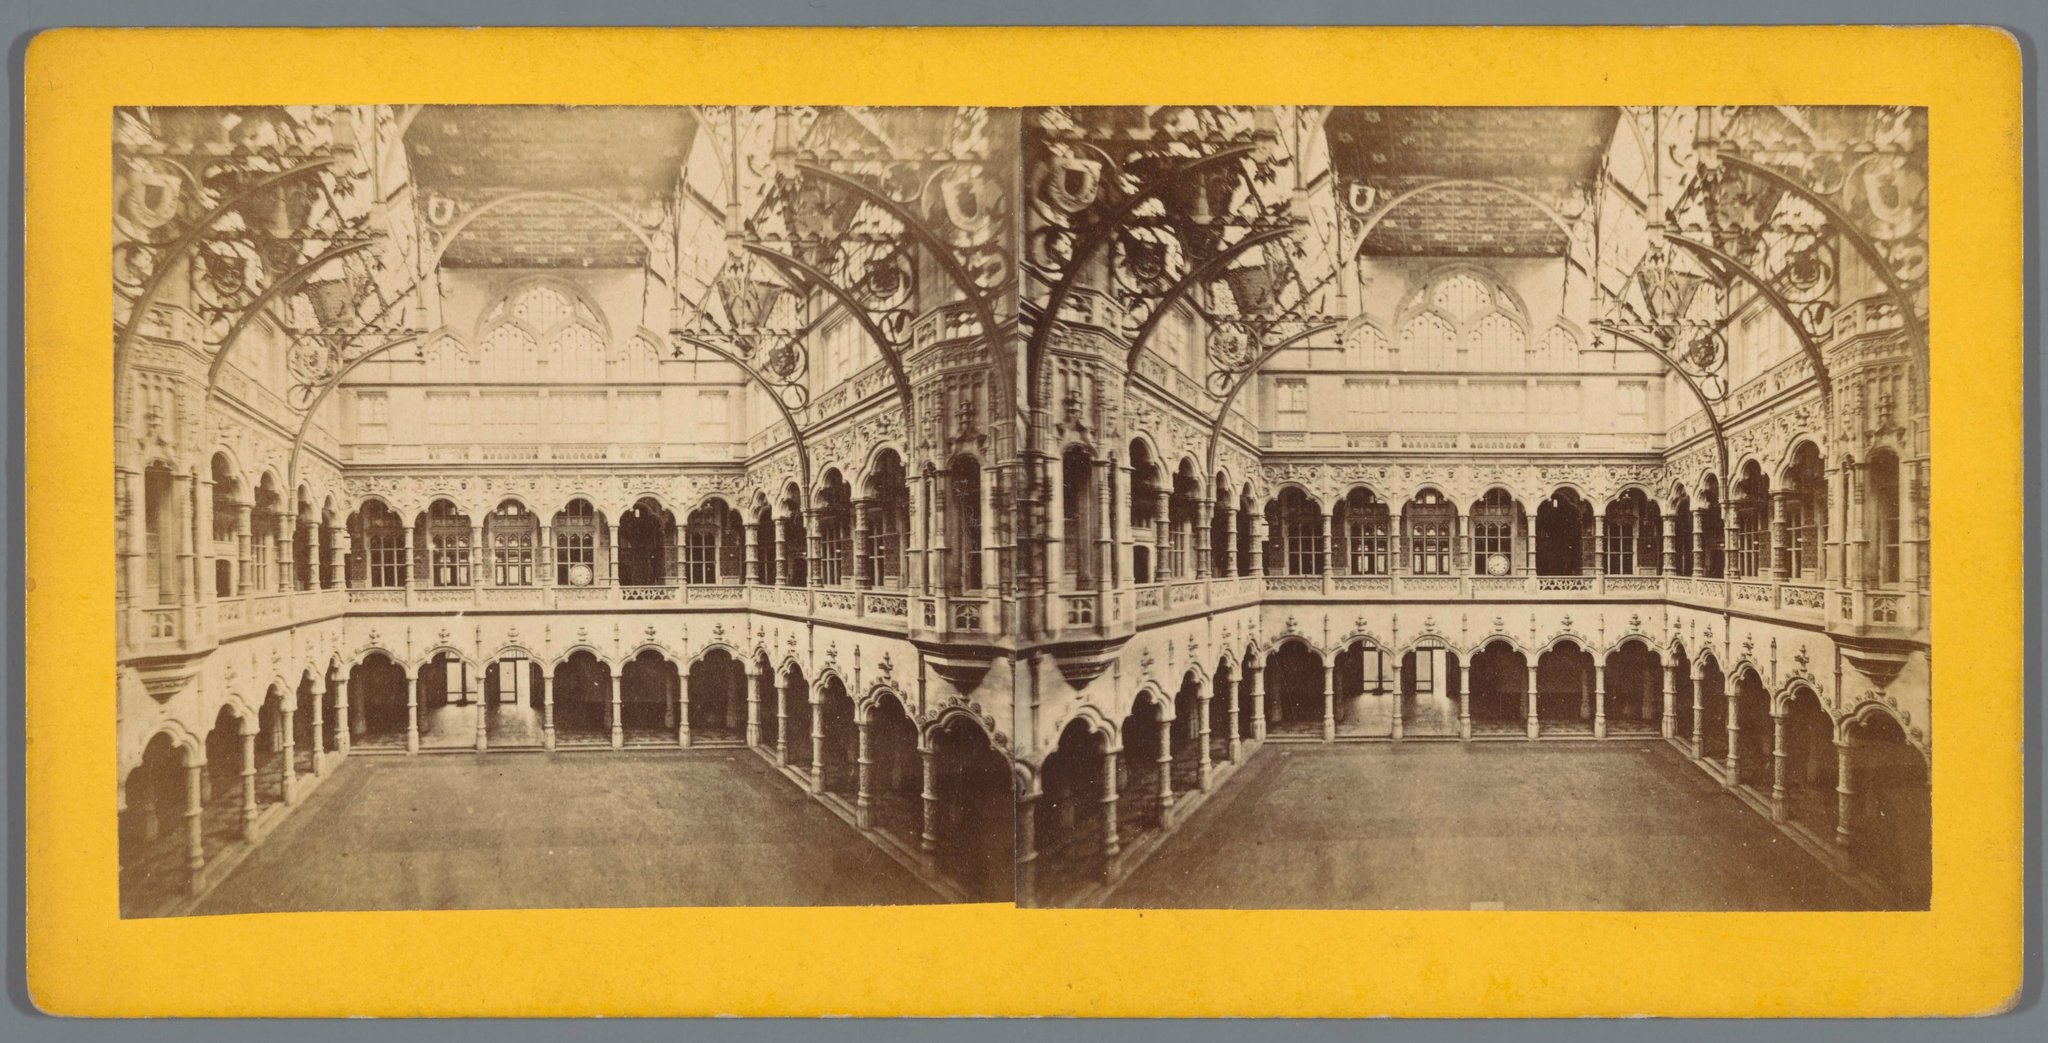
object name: stereograph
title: Interieur van het beursgebouw in Antwerpen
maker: Anonymous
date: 1873-1890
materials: cardboard, paper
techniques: albumen print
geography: antwerp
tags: exchange, bourse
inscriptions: inscription: ‘165’, stamp: ‘DREYFUS MICHEL/ ANVERS/ MACHE AUX SOLIERS 3’